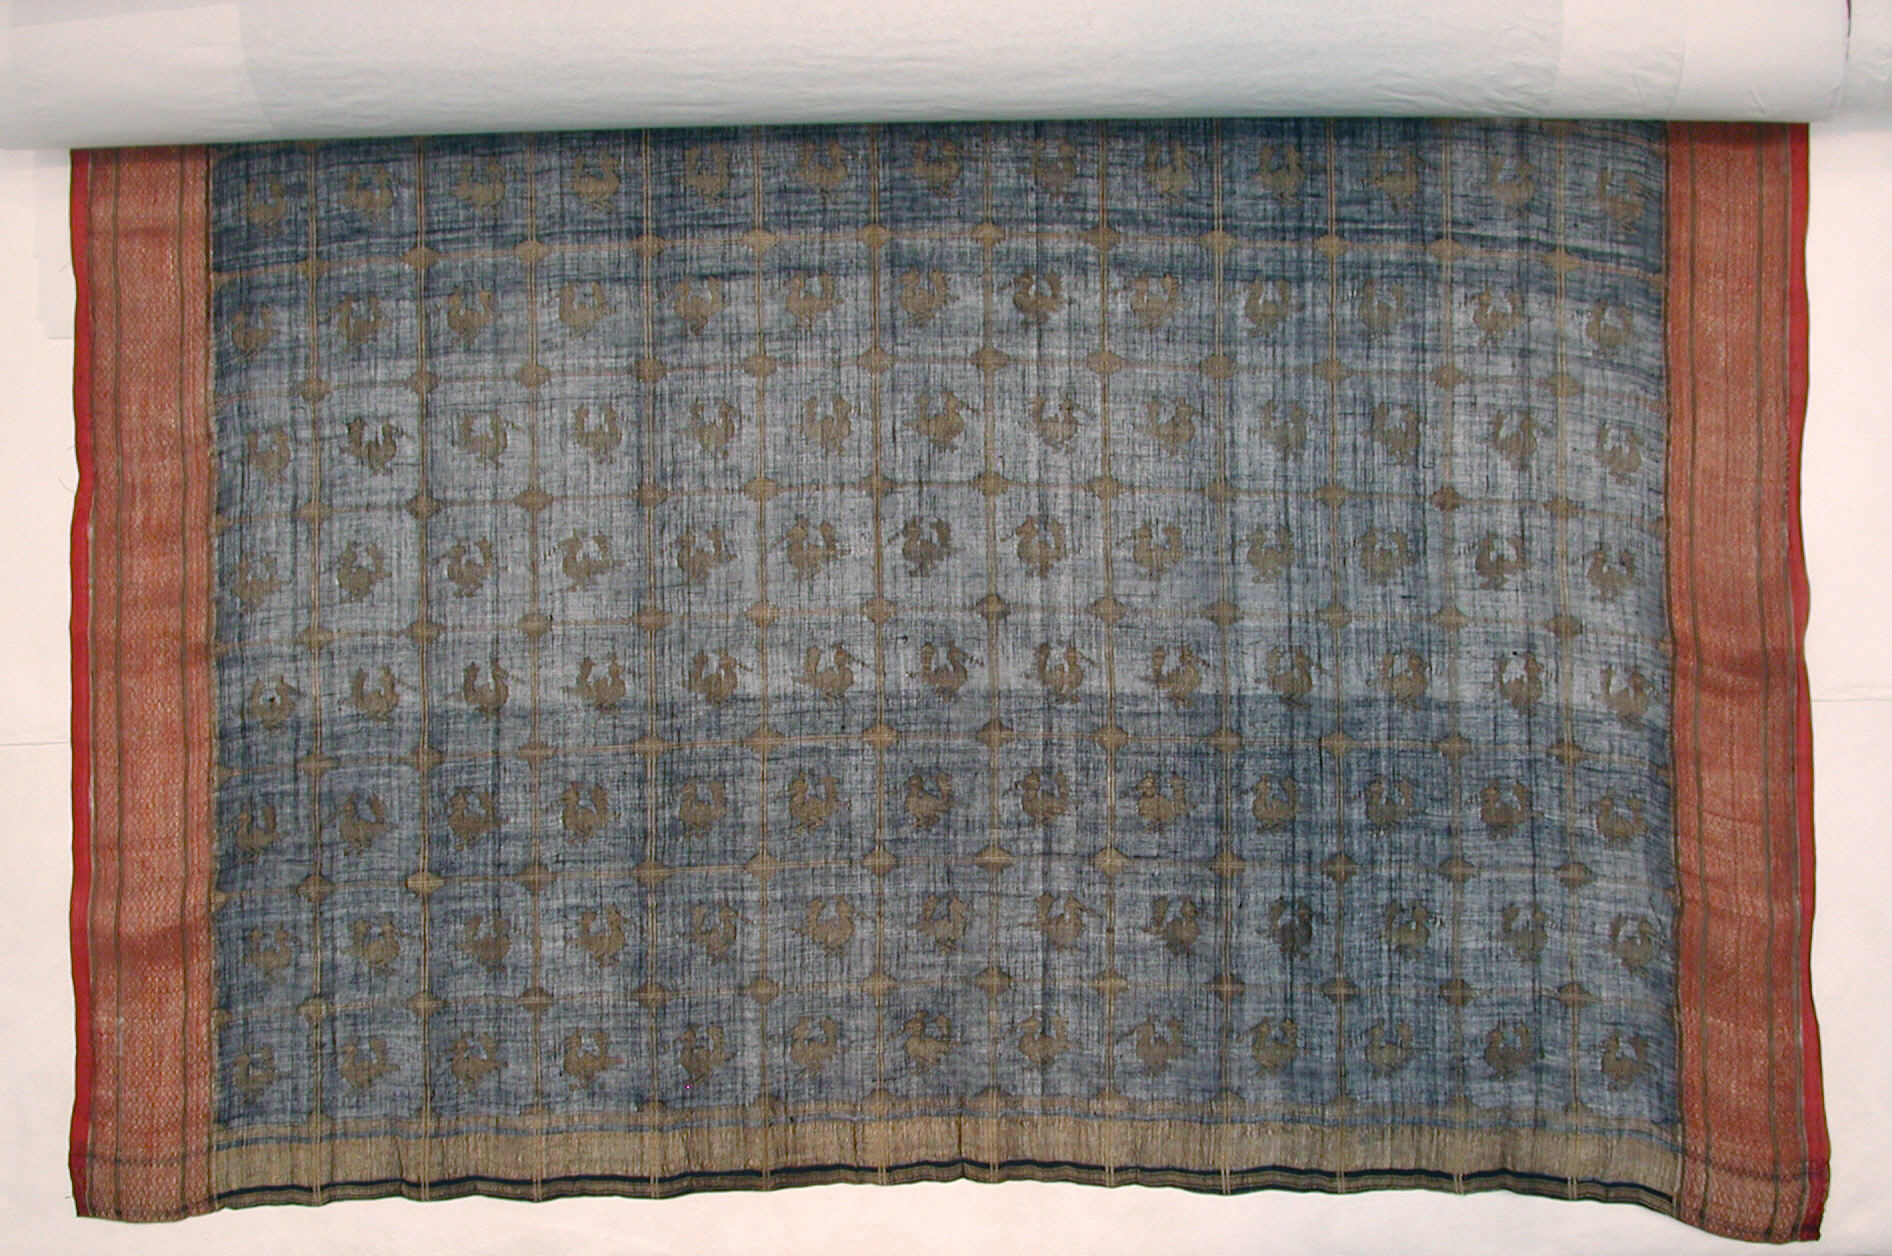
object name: sari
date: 1701-1800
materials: silk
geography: india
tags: birds